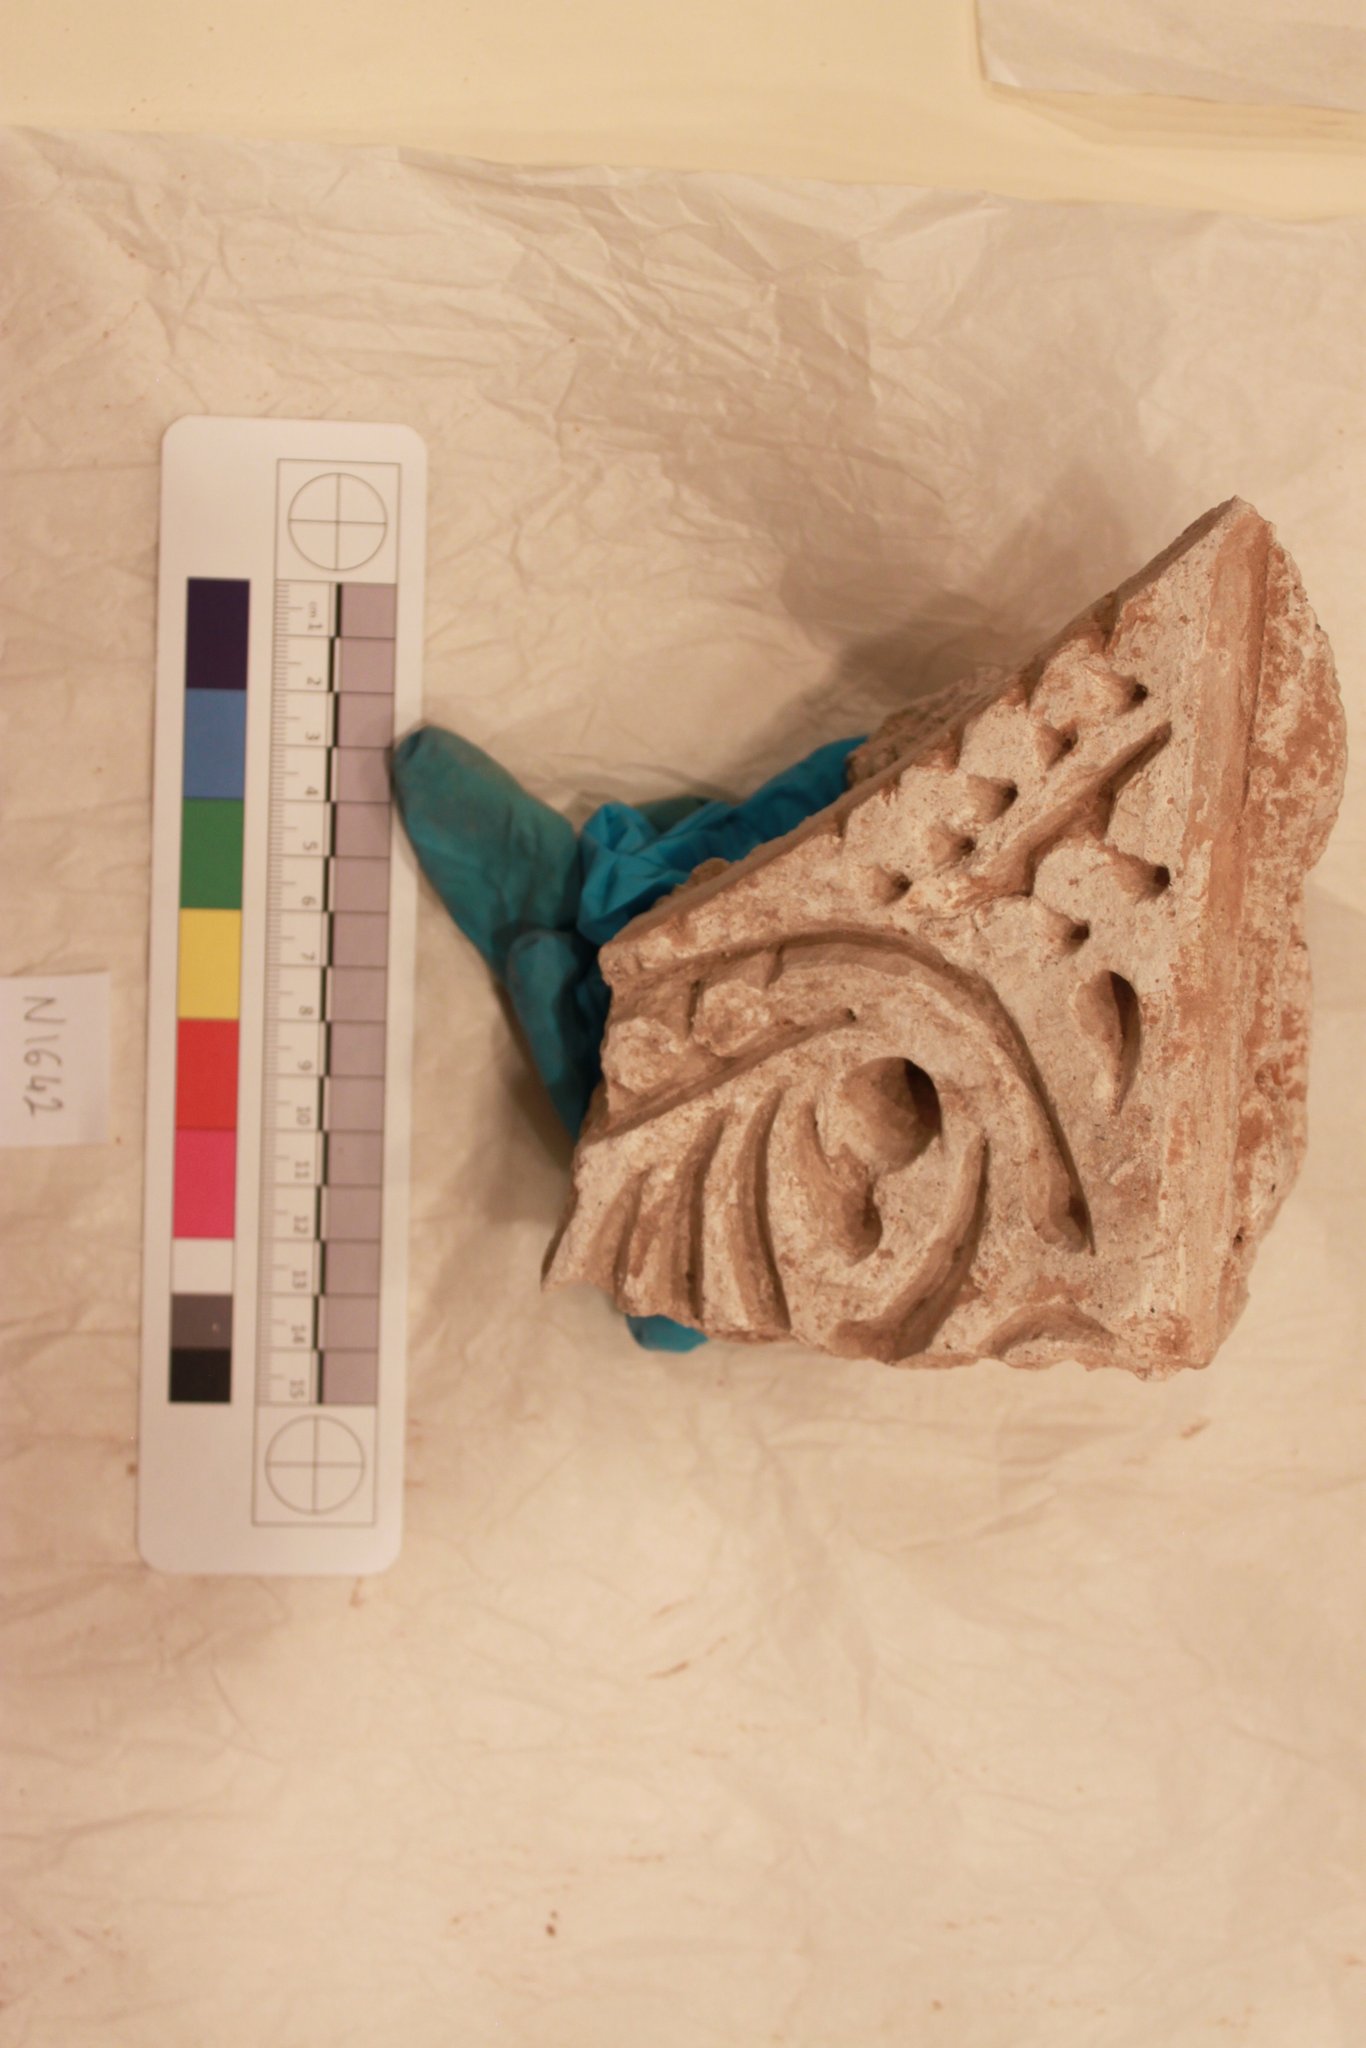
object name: fragment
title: Stucco Fragment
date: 701-1200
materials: plaster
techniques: carving, painting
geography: iran